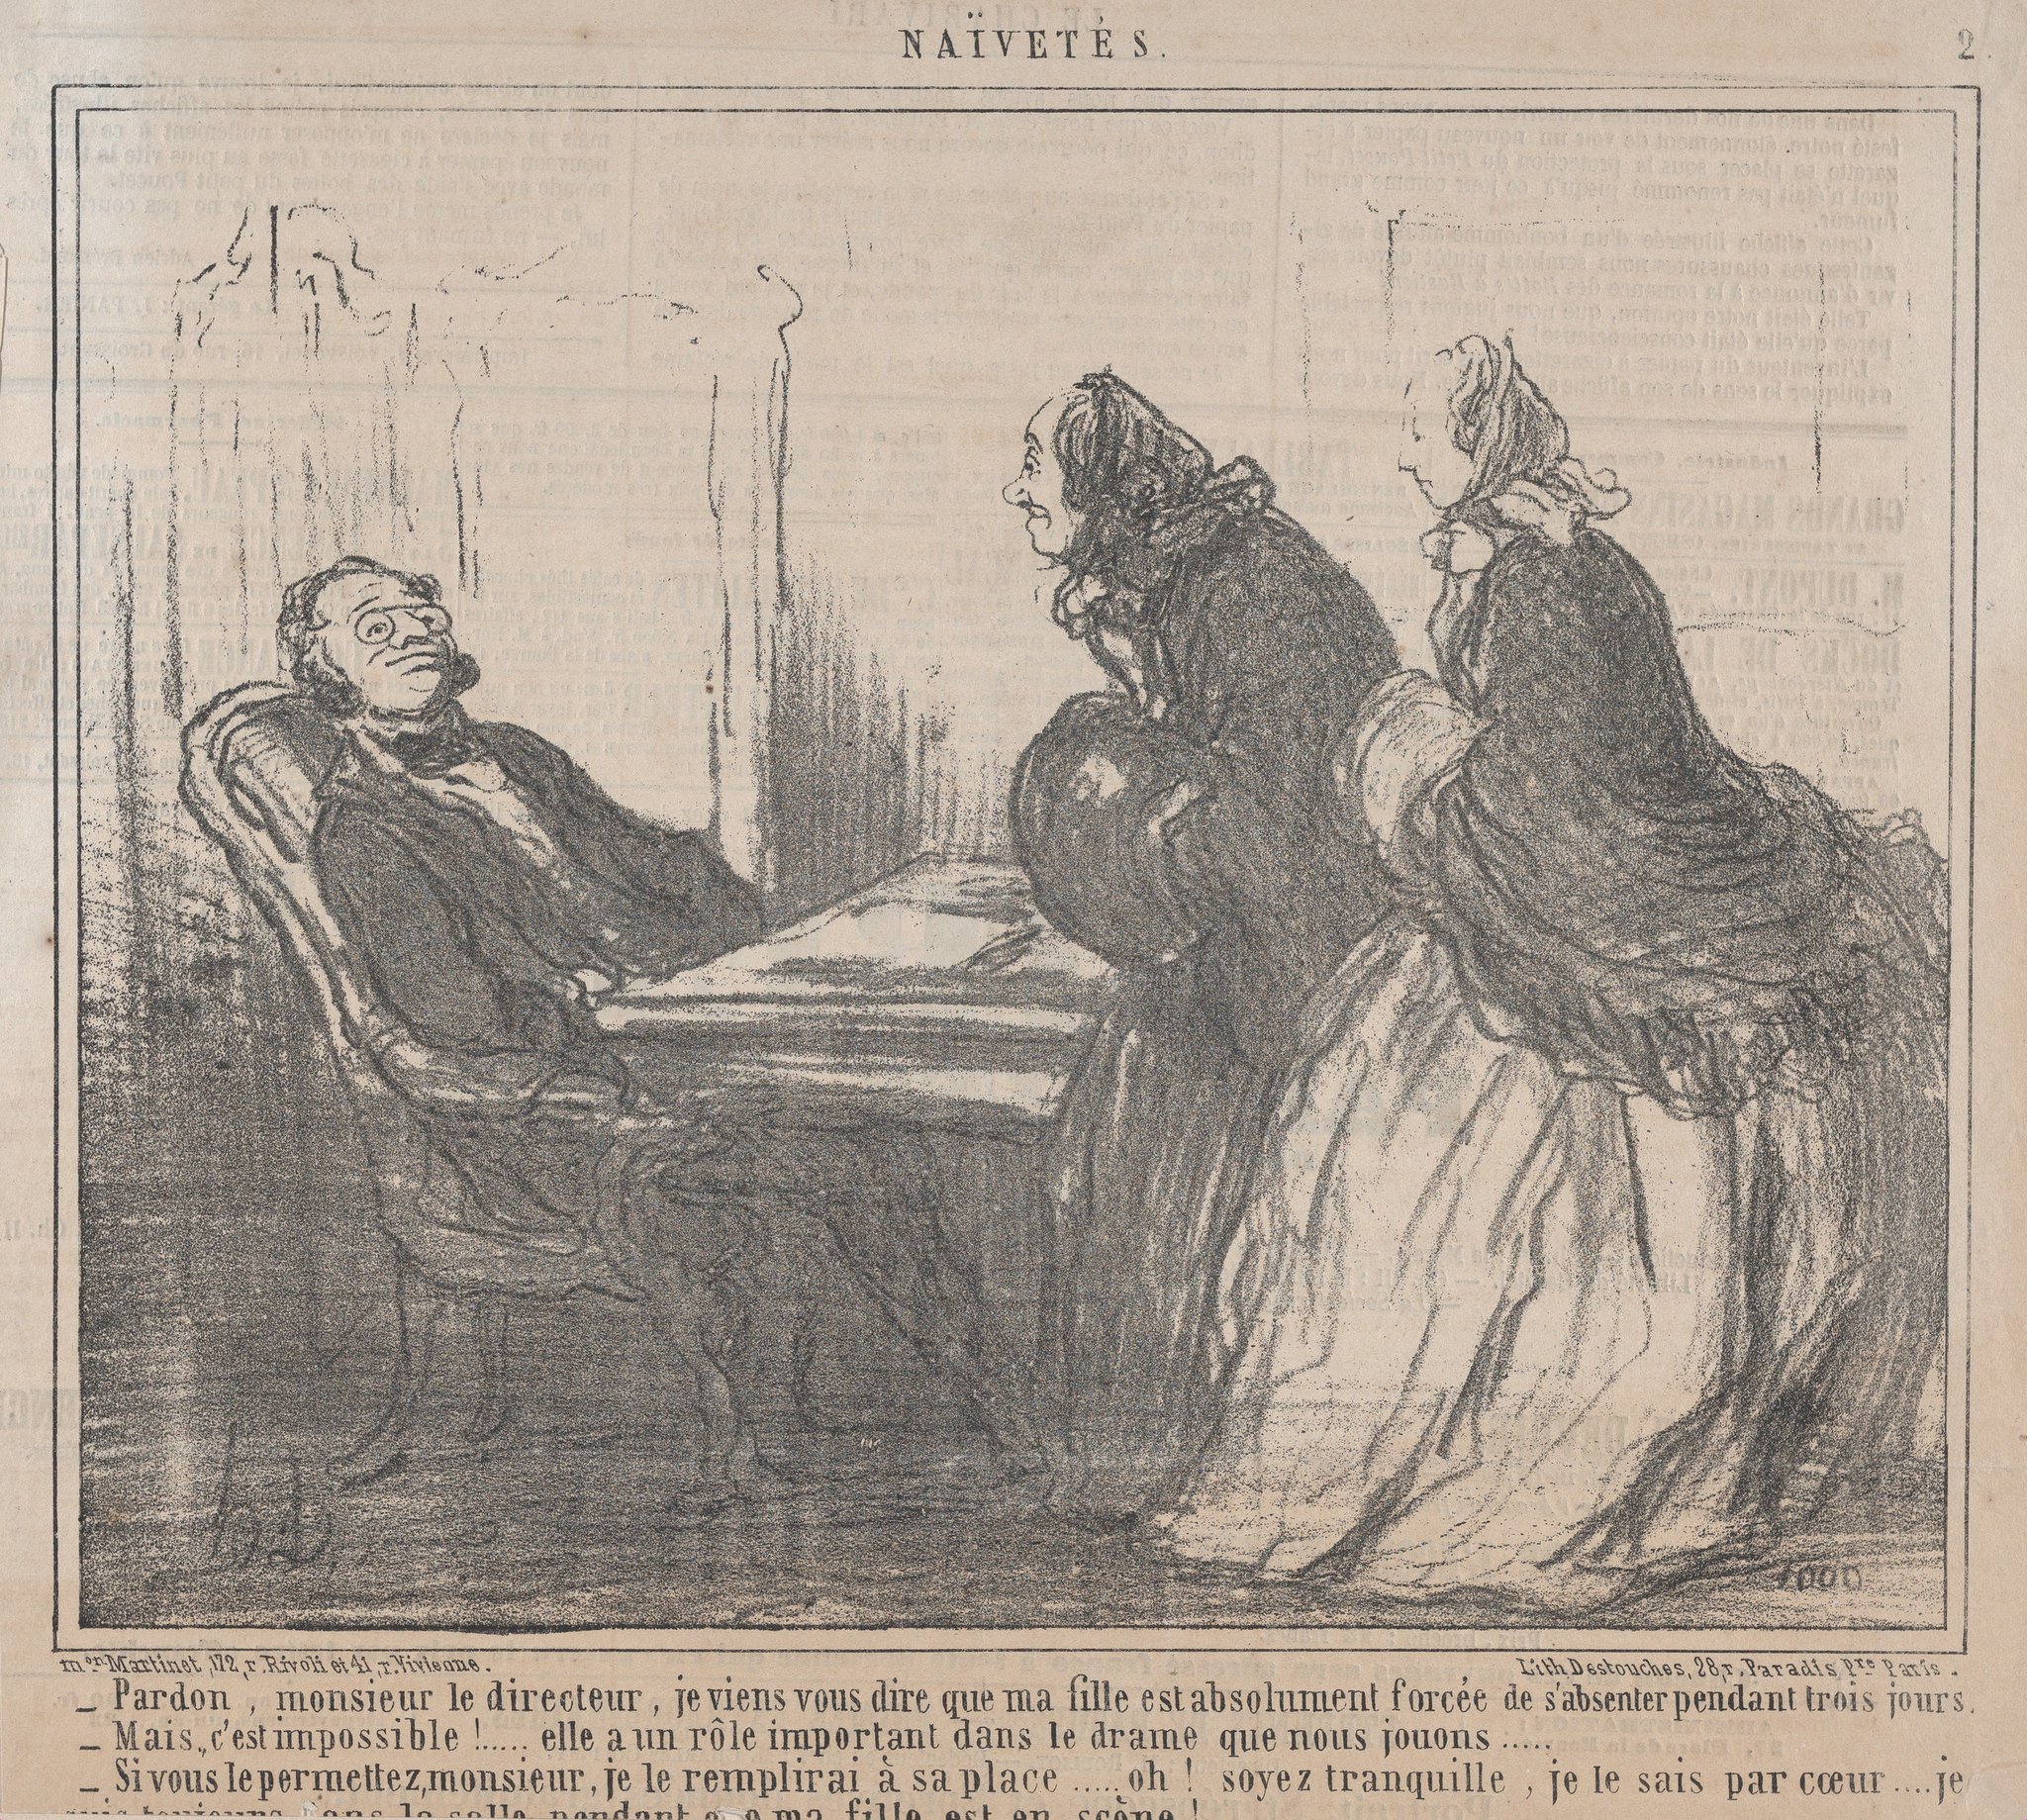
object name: print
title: Pardon, monsieur le directeur..., from "Naïvetés"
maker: honoré daumier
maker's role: artist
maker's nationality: french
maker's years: 1808-1879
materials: paper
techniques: lithograph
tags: men,women